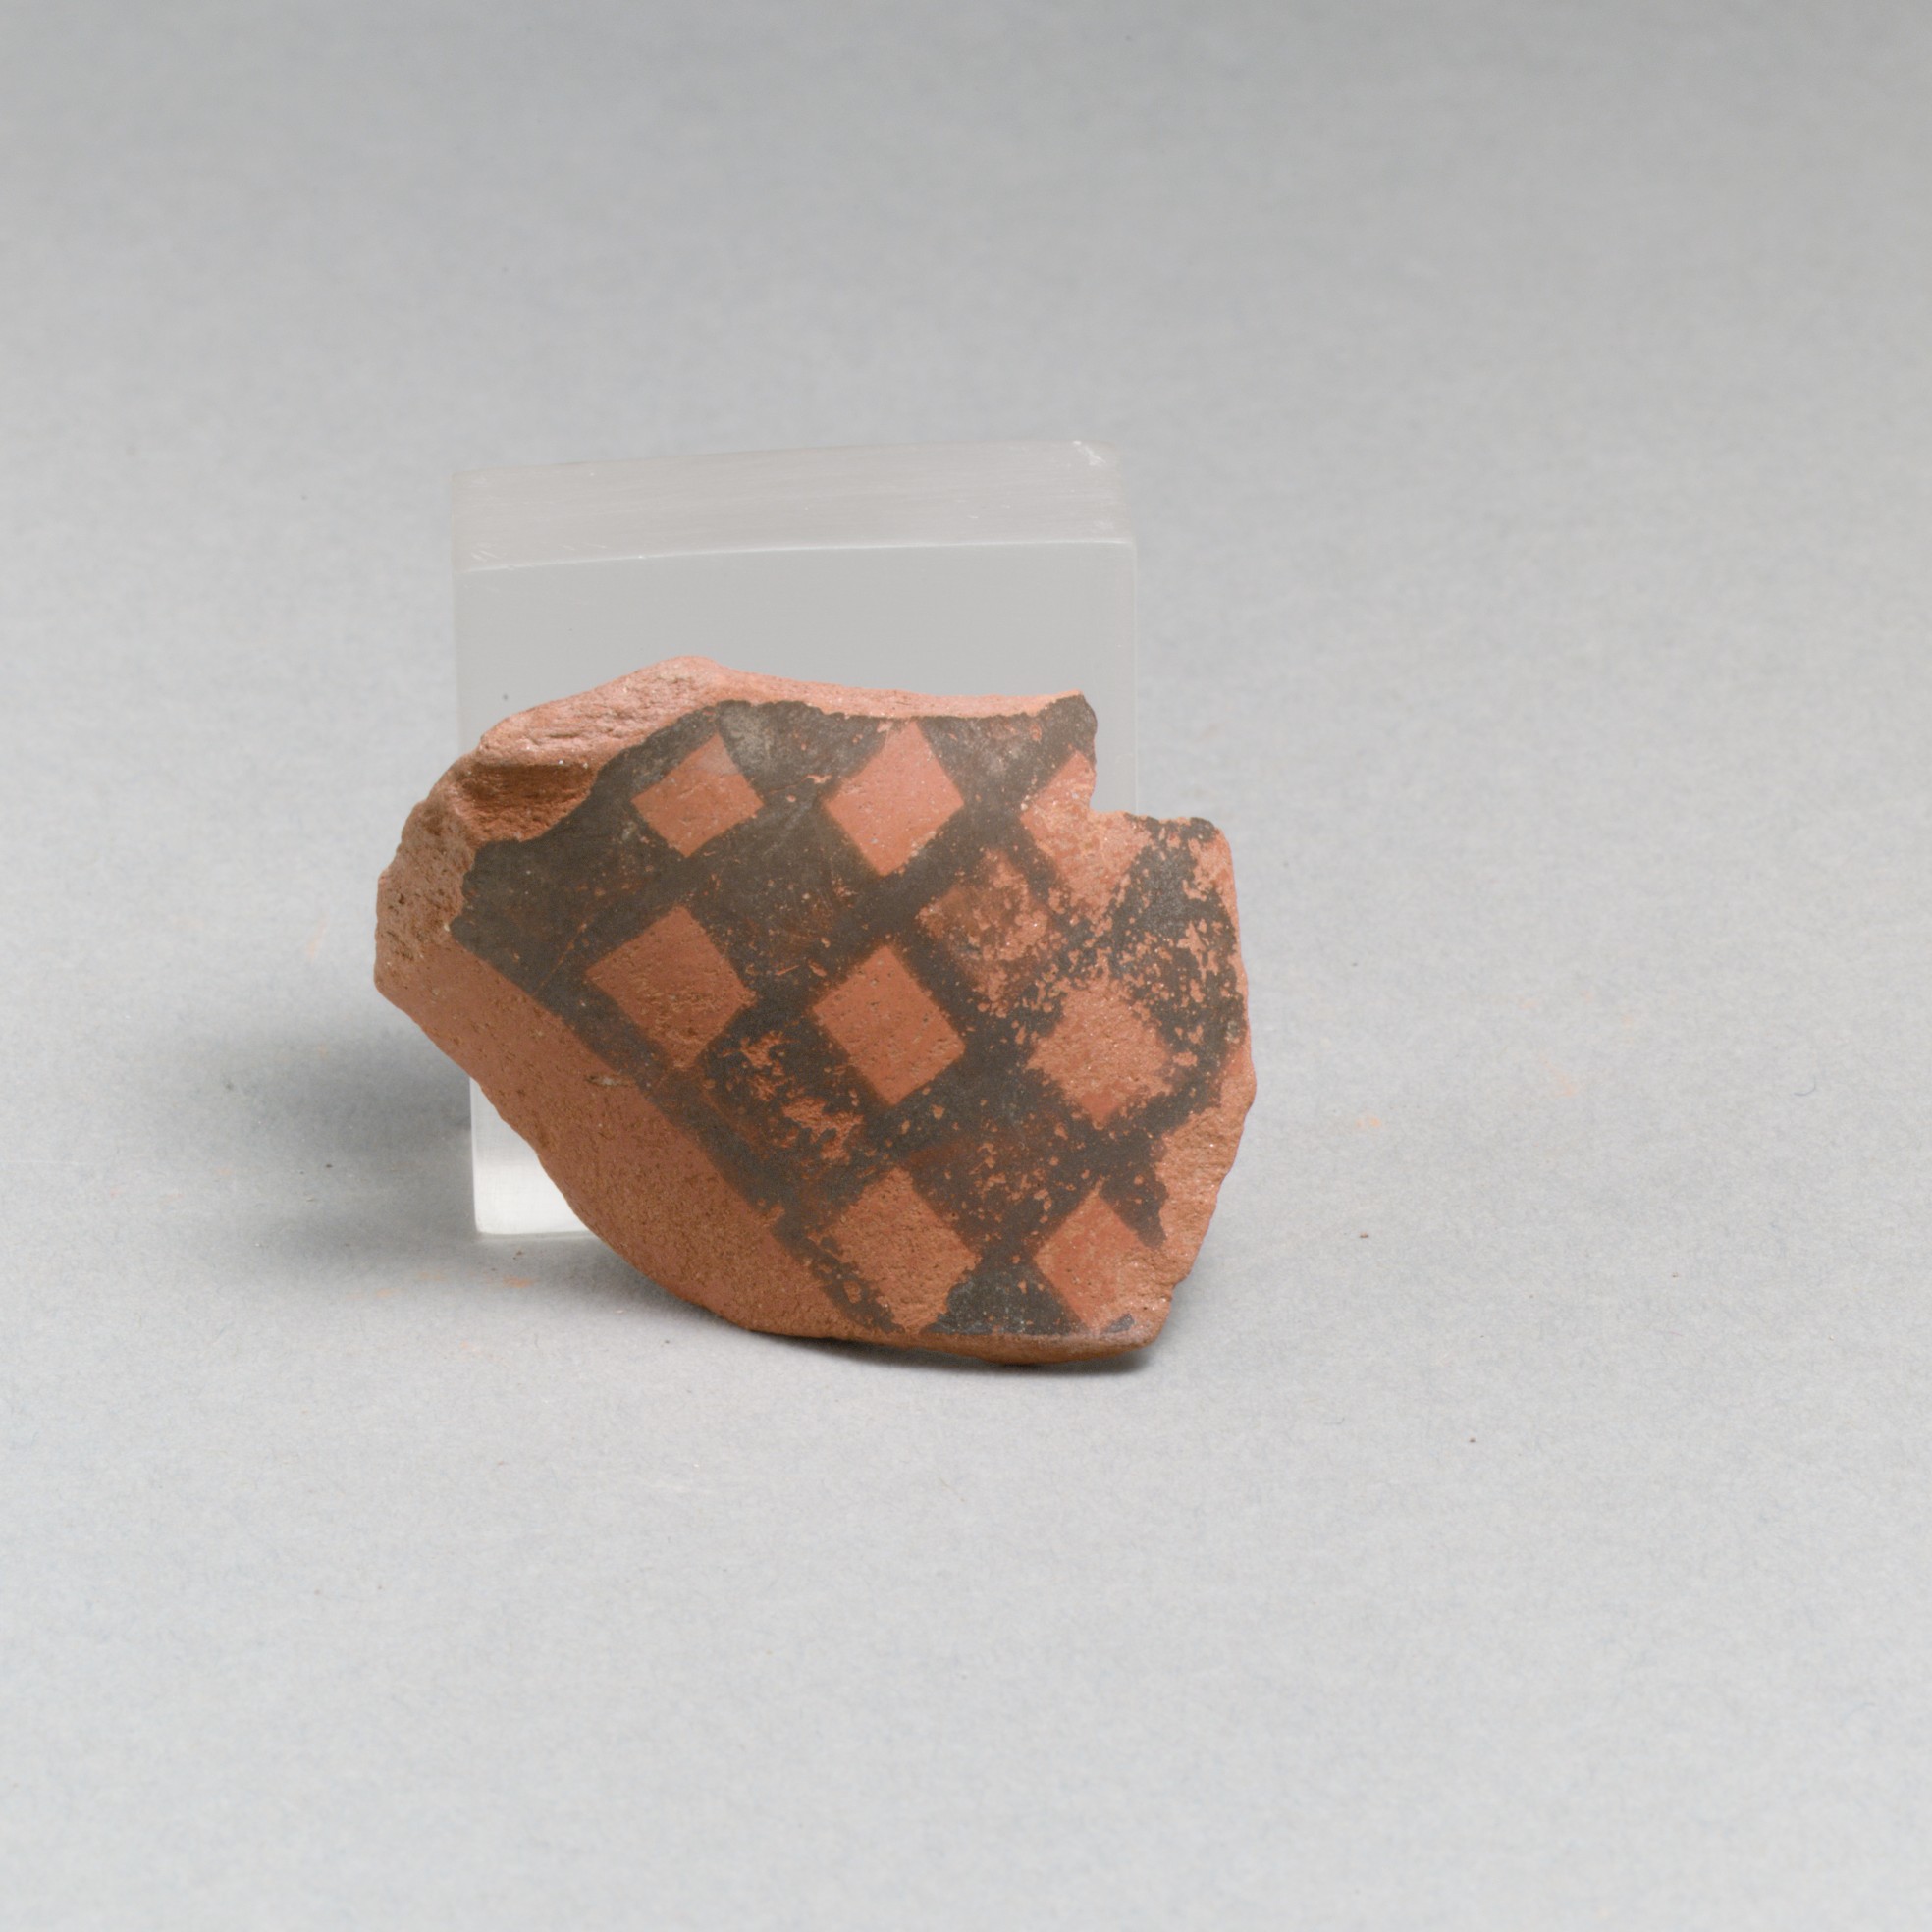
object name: vase fragment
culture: greek or lydian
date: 1050-700 BCE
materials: terracotta